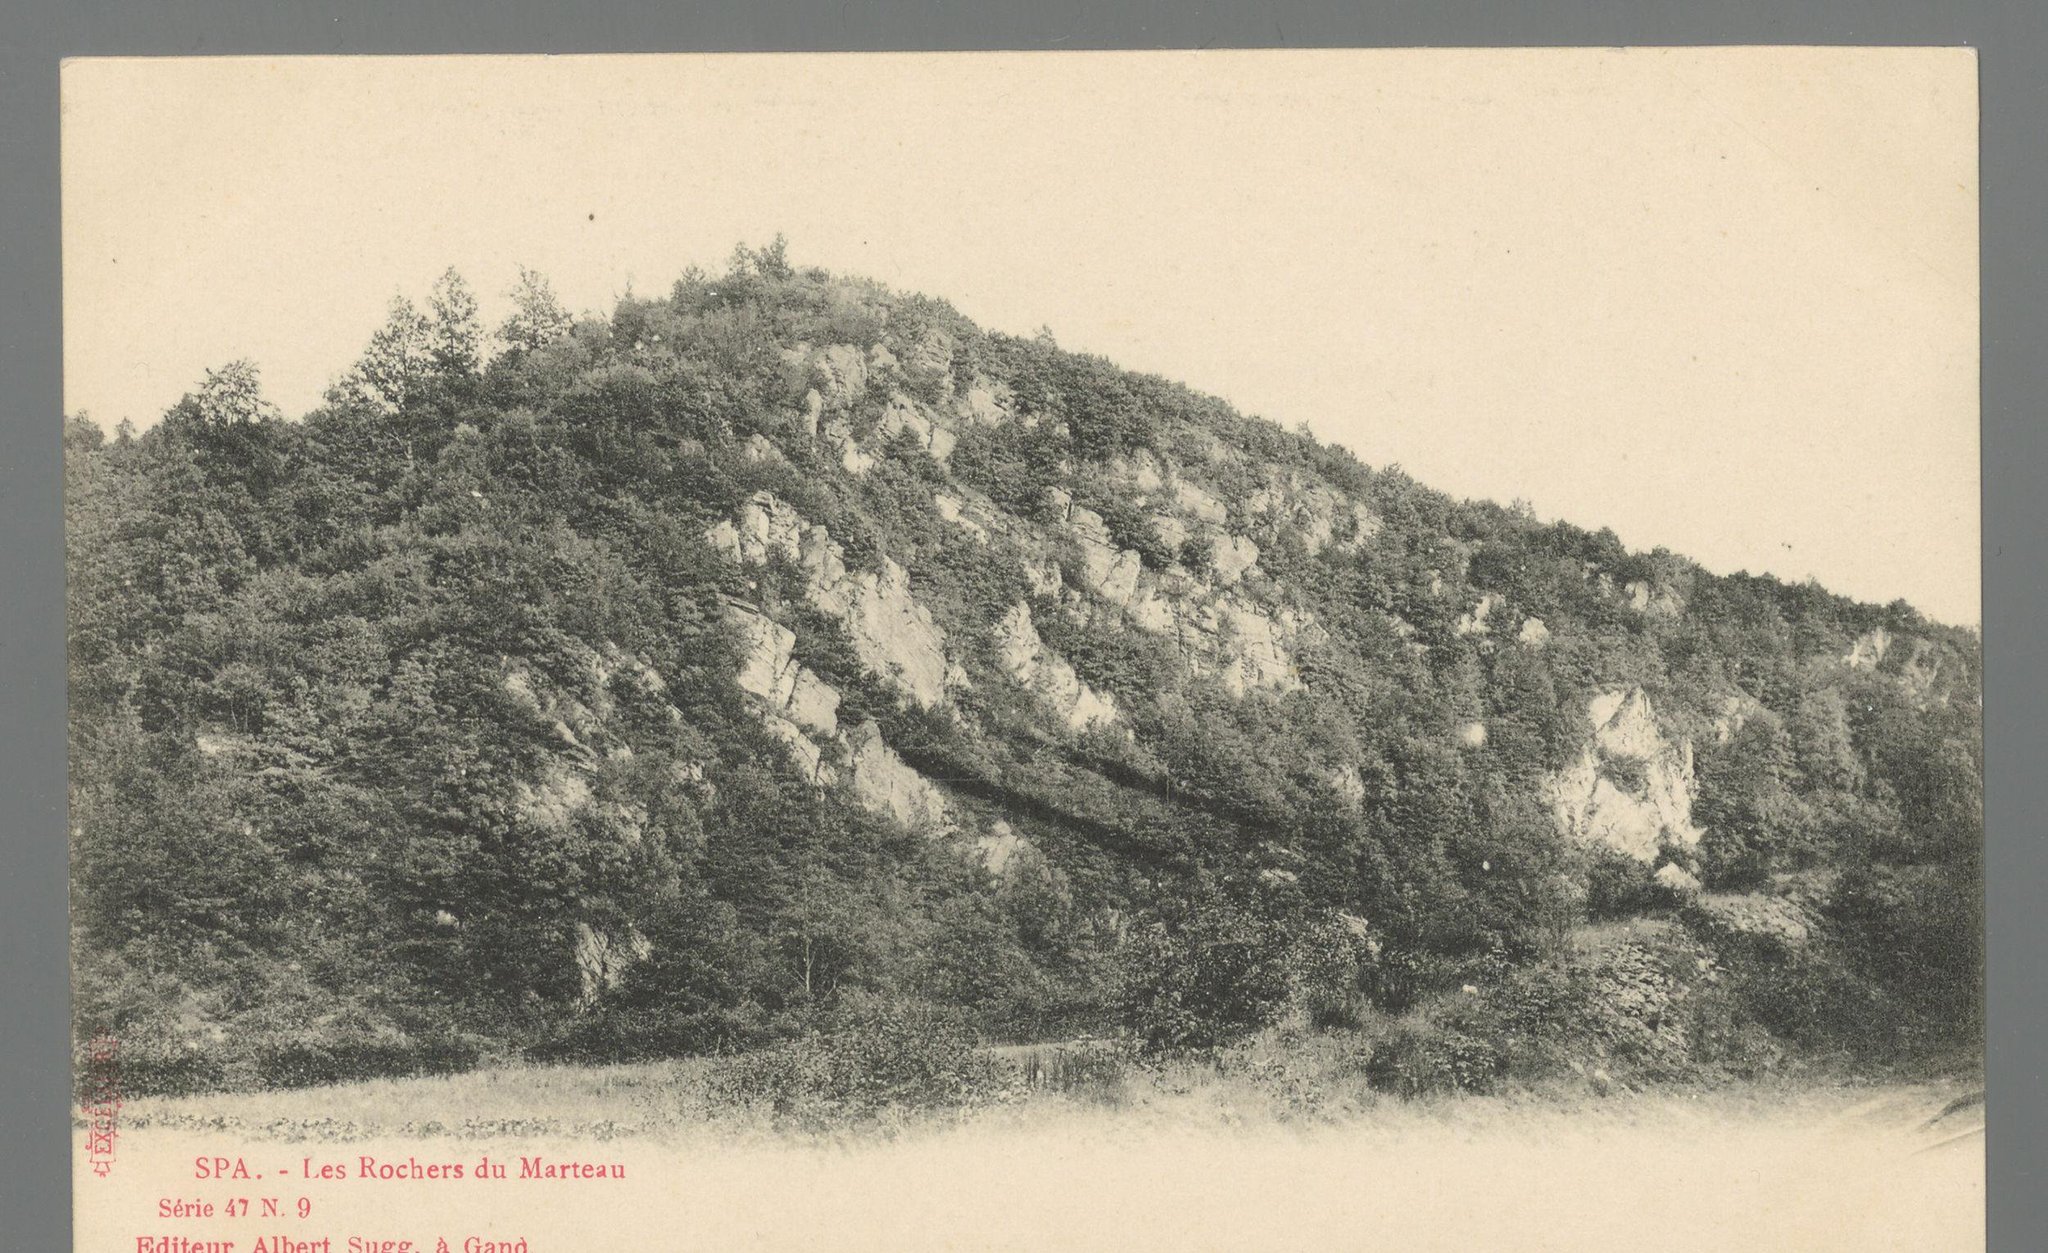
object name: photomechanical print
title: Série 47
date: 1896-1906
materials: cardboard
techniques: photograph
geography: ghent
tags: landscapes, rock-formations